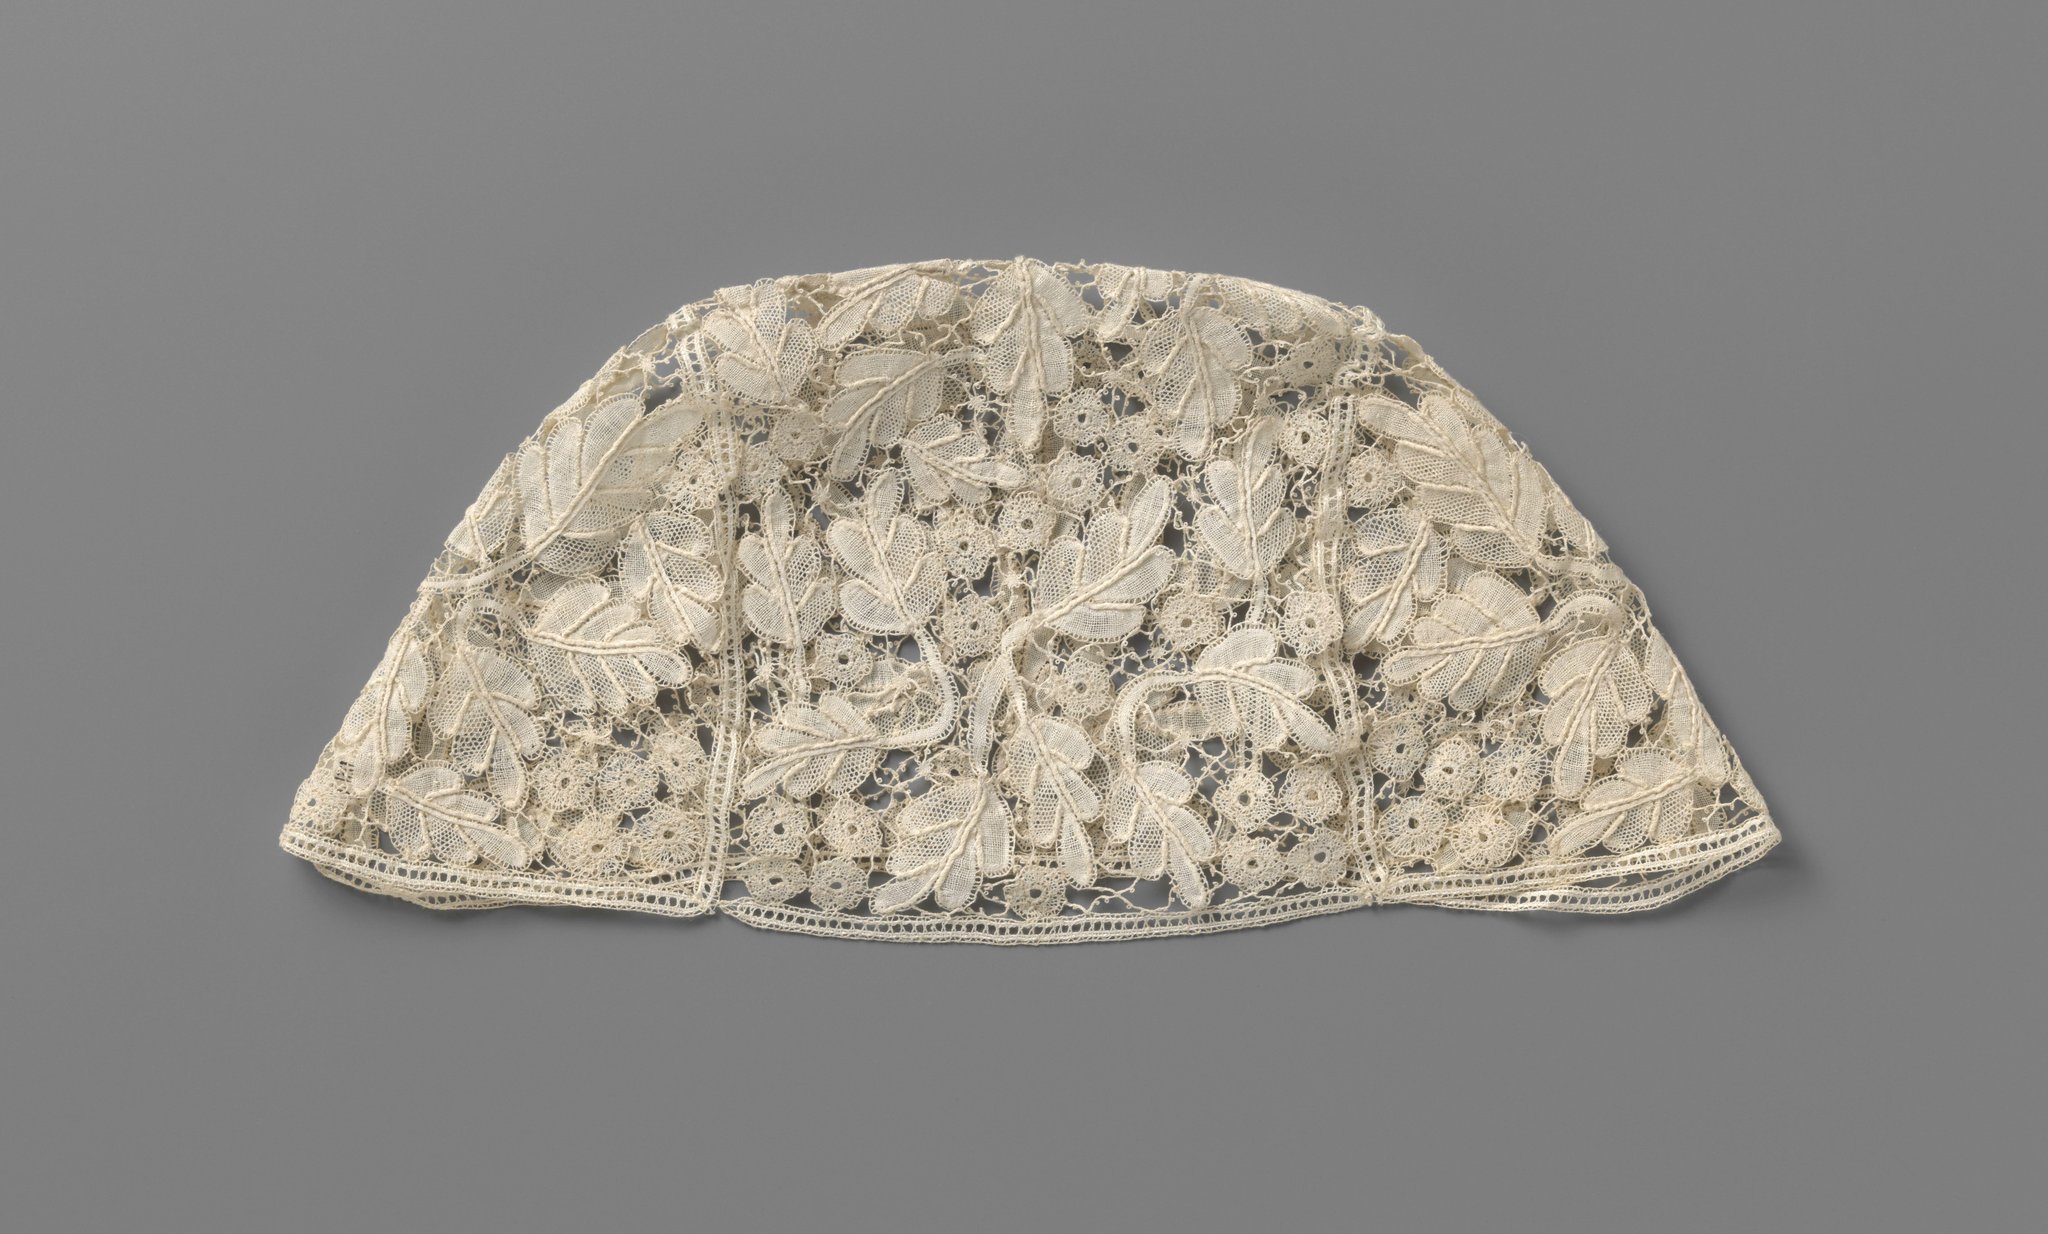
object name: cap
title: Muts van kloskant met eikeblaadjes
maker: martha berkers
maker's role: kantwerkster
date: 1914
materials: linen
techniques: lace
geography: sluis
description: Muts van naturelkleurige kloskant, duchesse-kant. Het model is driedelig; twee ruitvormige zijstukken en een rechtheokige middenbaan zijn door een lisière, d.i. aannaaibandje, omgeven. De kant heeft een open spijlenfond en een asymmetrisch patroon van losse roosjes en eikeblaadjes, die tot rozetten geschikt zijn.